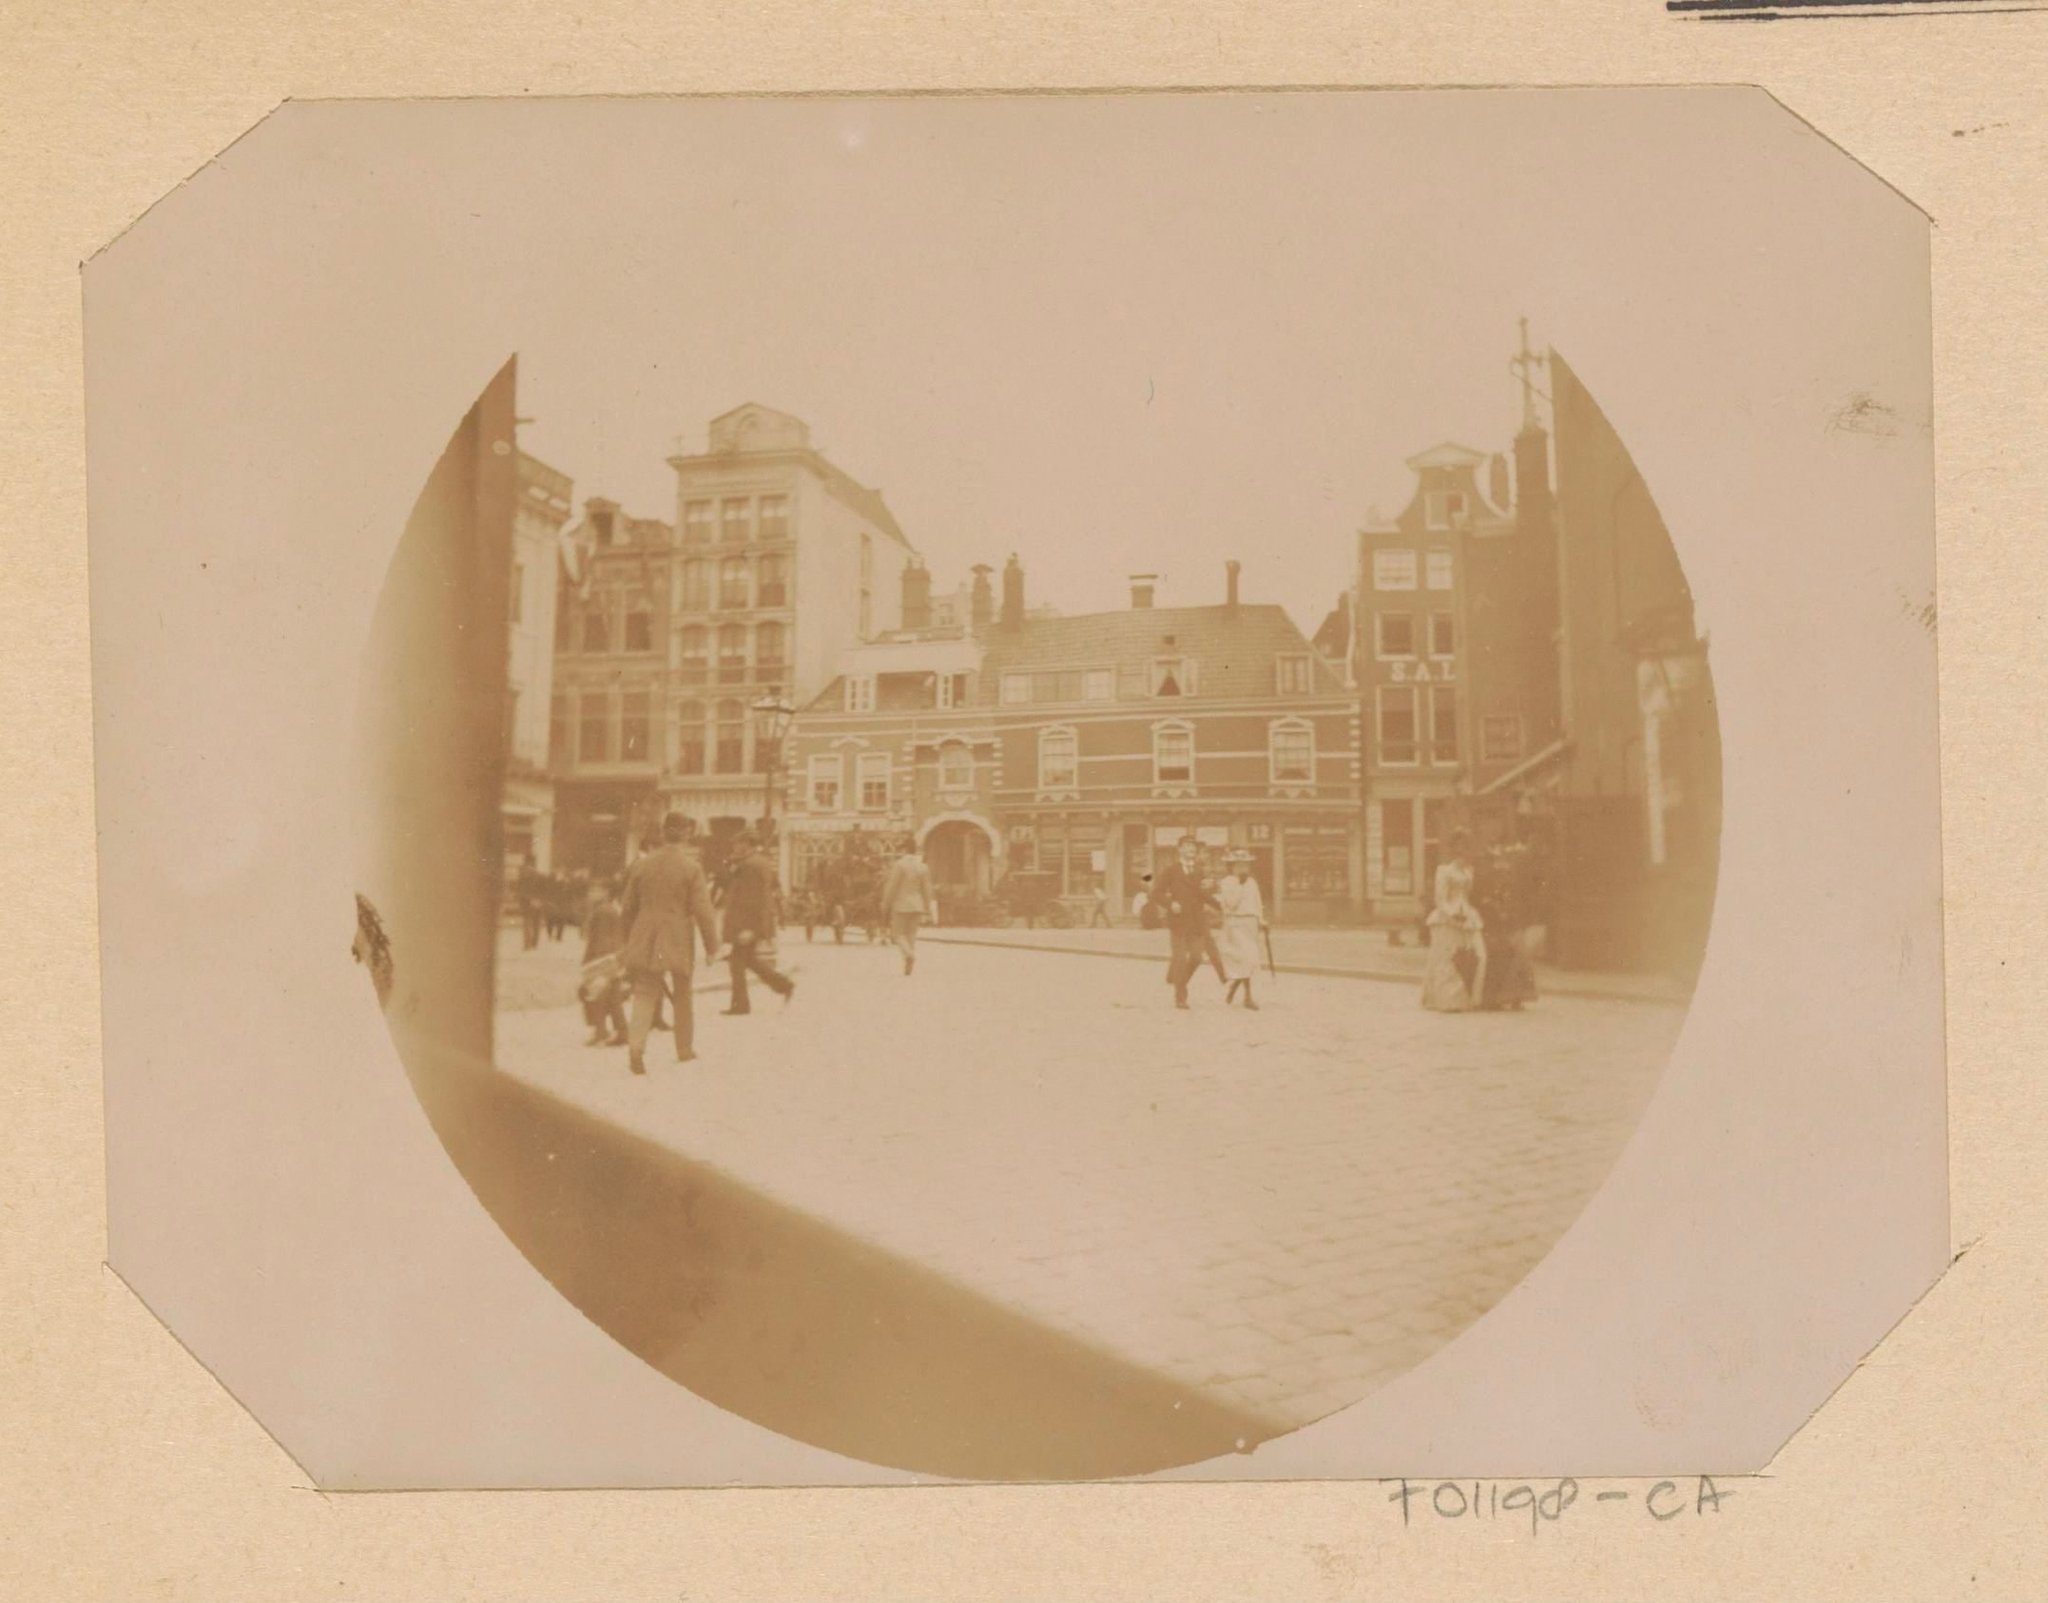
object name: album leaf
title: Gezicht op de Dam met op de achtergrond het Beurspoortje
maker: johanna margaretha piek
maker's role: fotograaf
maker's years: 1870-1947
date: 1891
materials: paper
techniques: gelatin silver print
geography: amsterdam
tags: square, place, circus, etc., imperial celebrations 1891